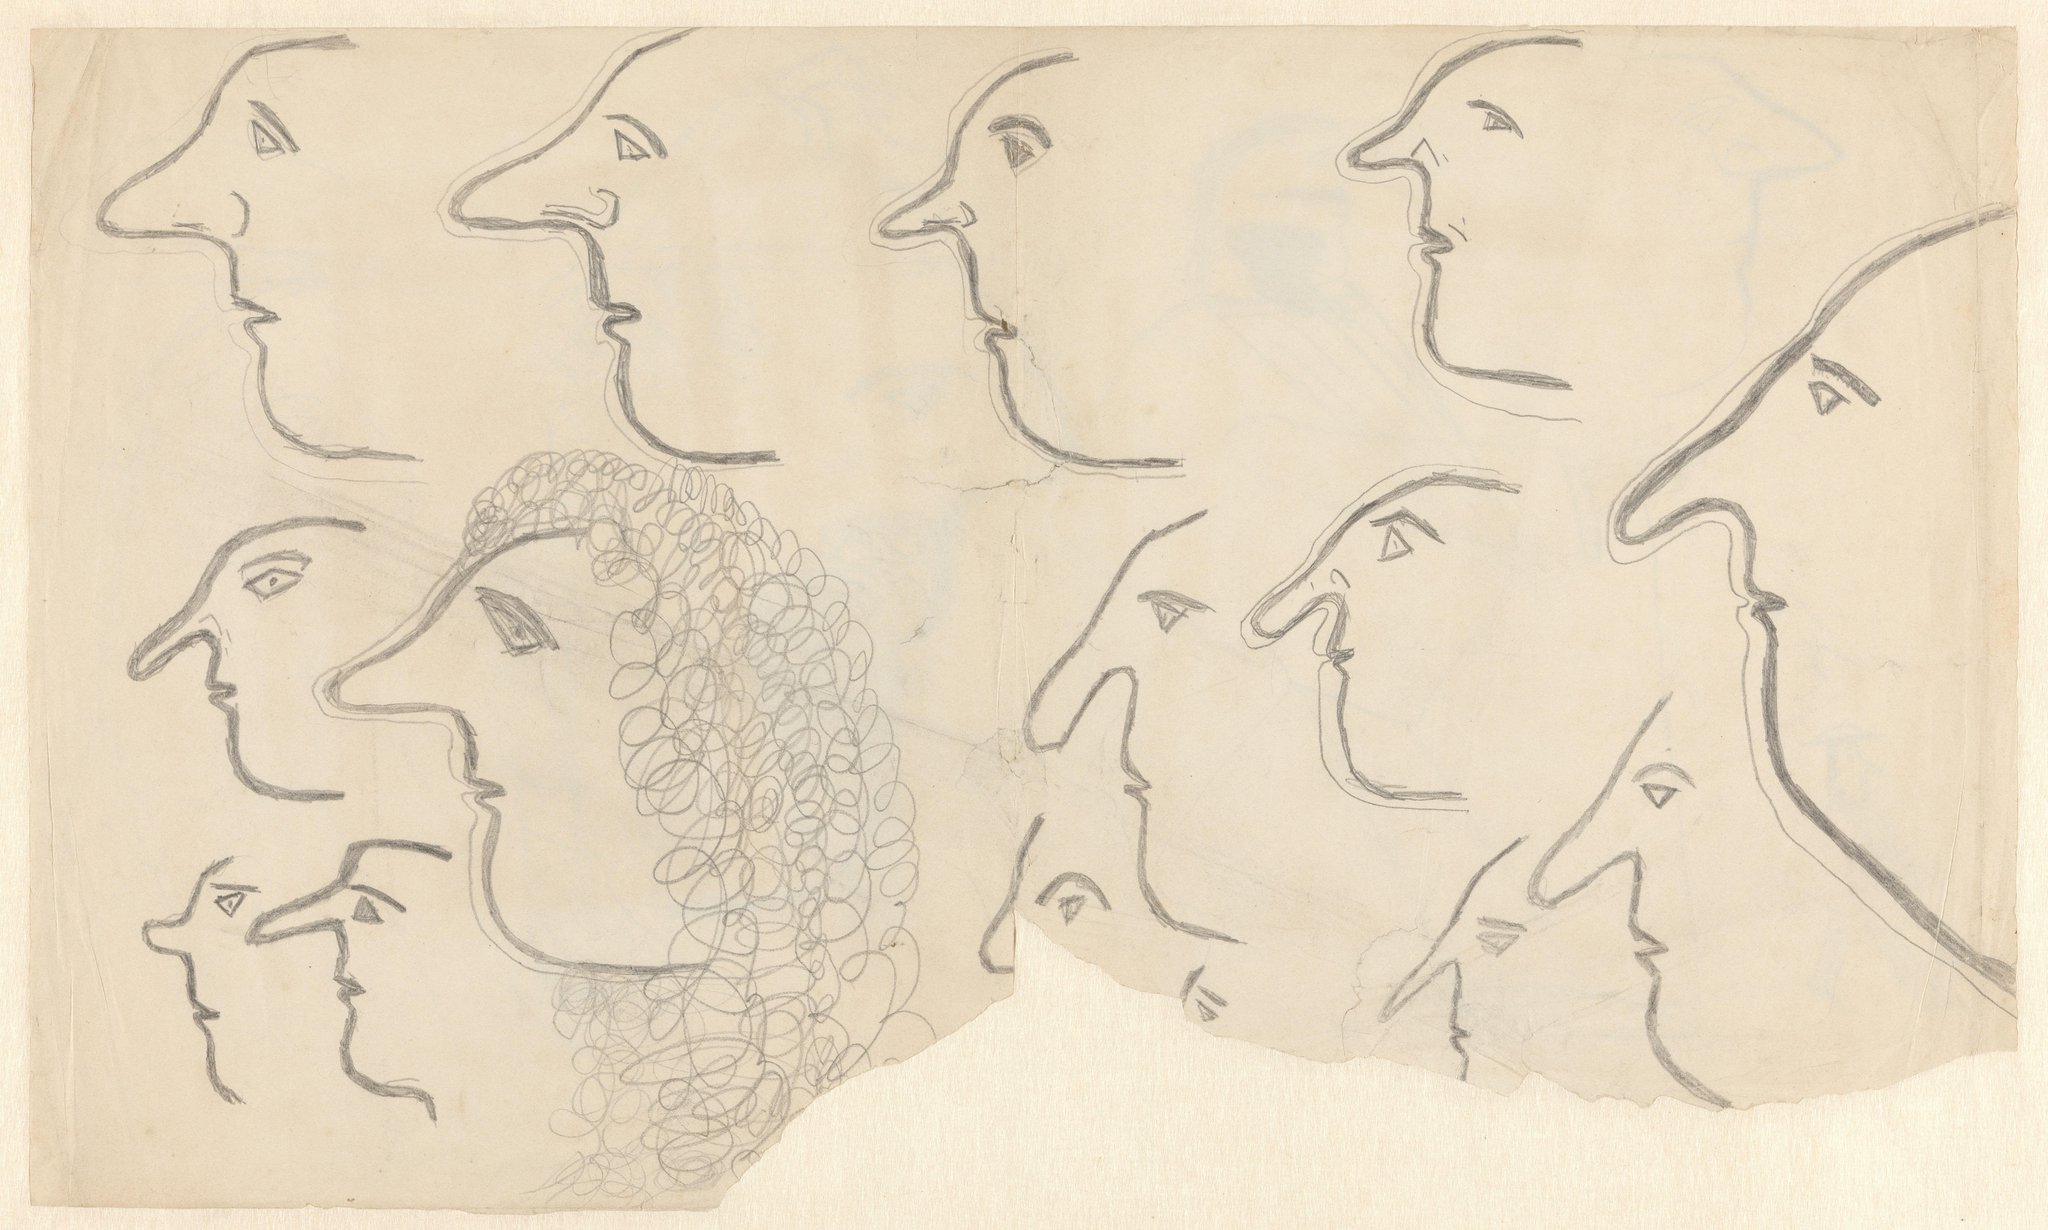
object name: drawing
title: Kindertekening met gezichten en profil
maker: Anonymous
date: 1853-1880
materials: paper, pencil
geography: netherlands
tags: face, parts of the face: nose